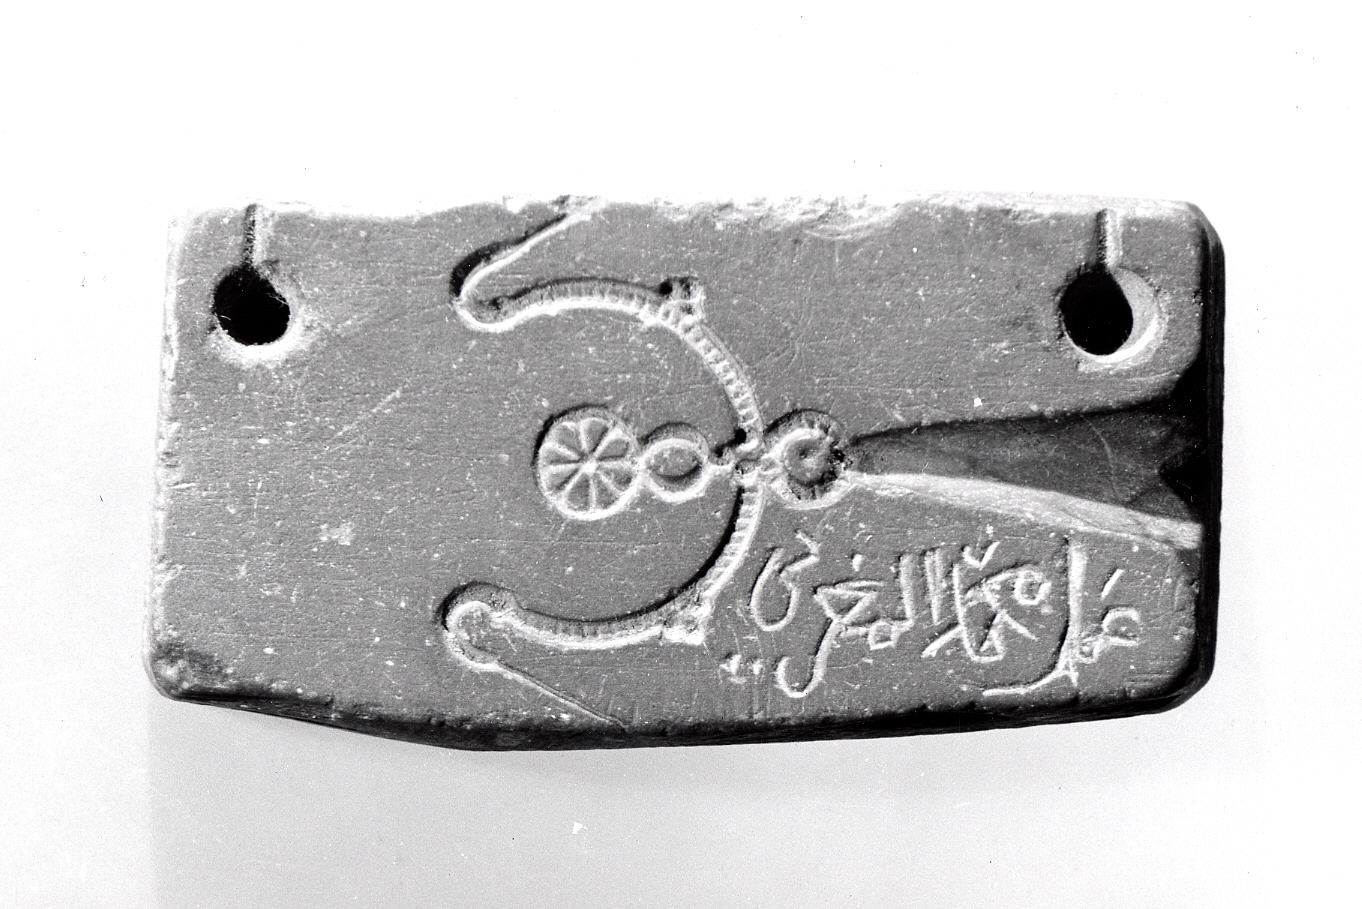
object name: jewelry mold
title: Mold for Jewelry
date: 901-1100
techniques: carving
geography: egypt